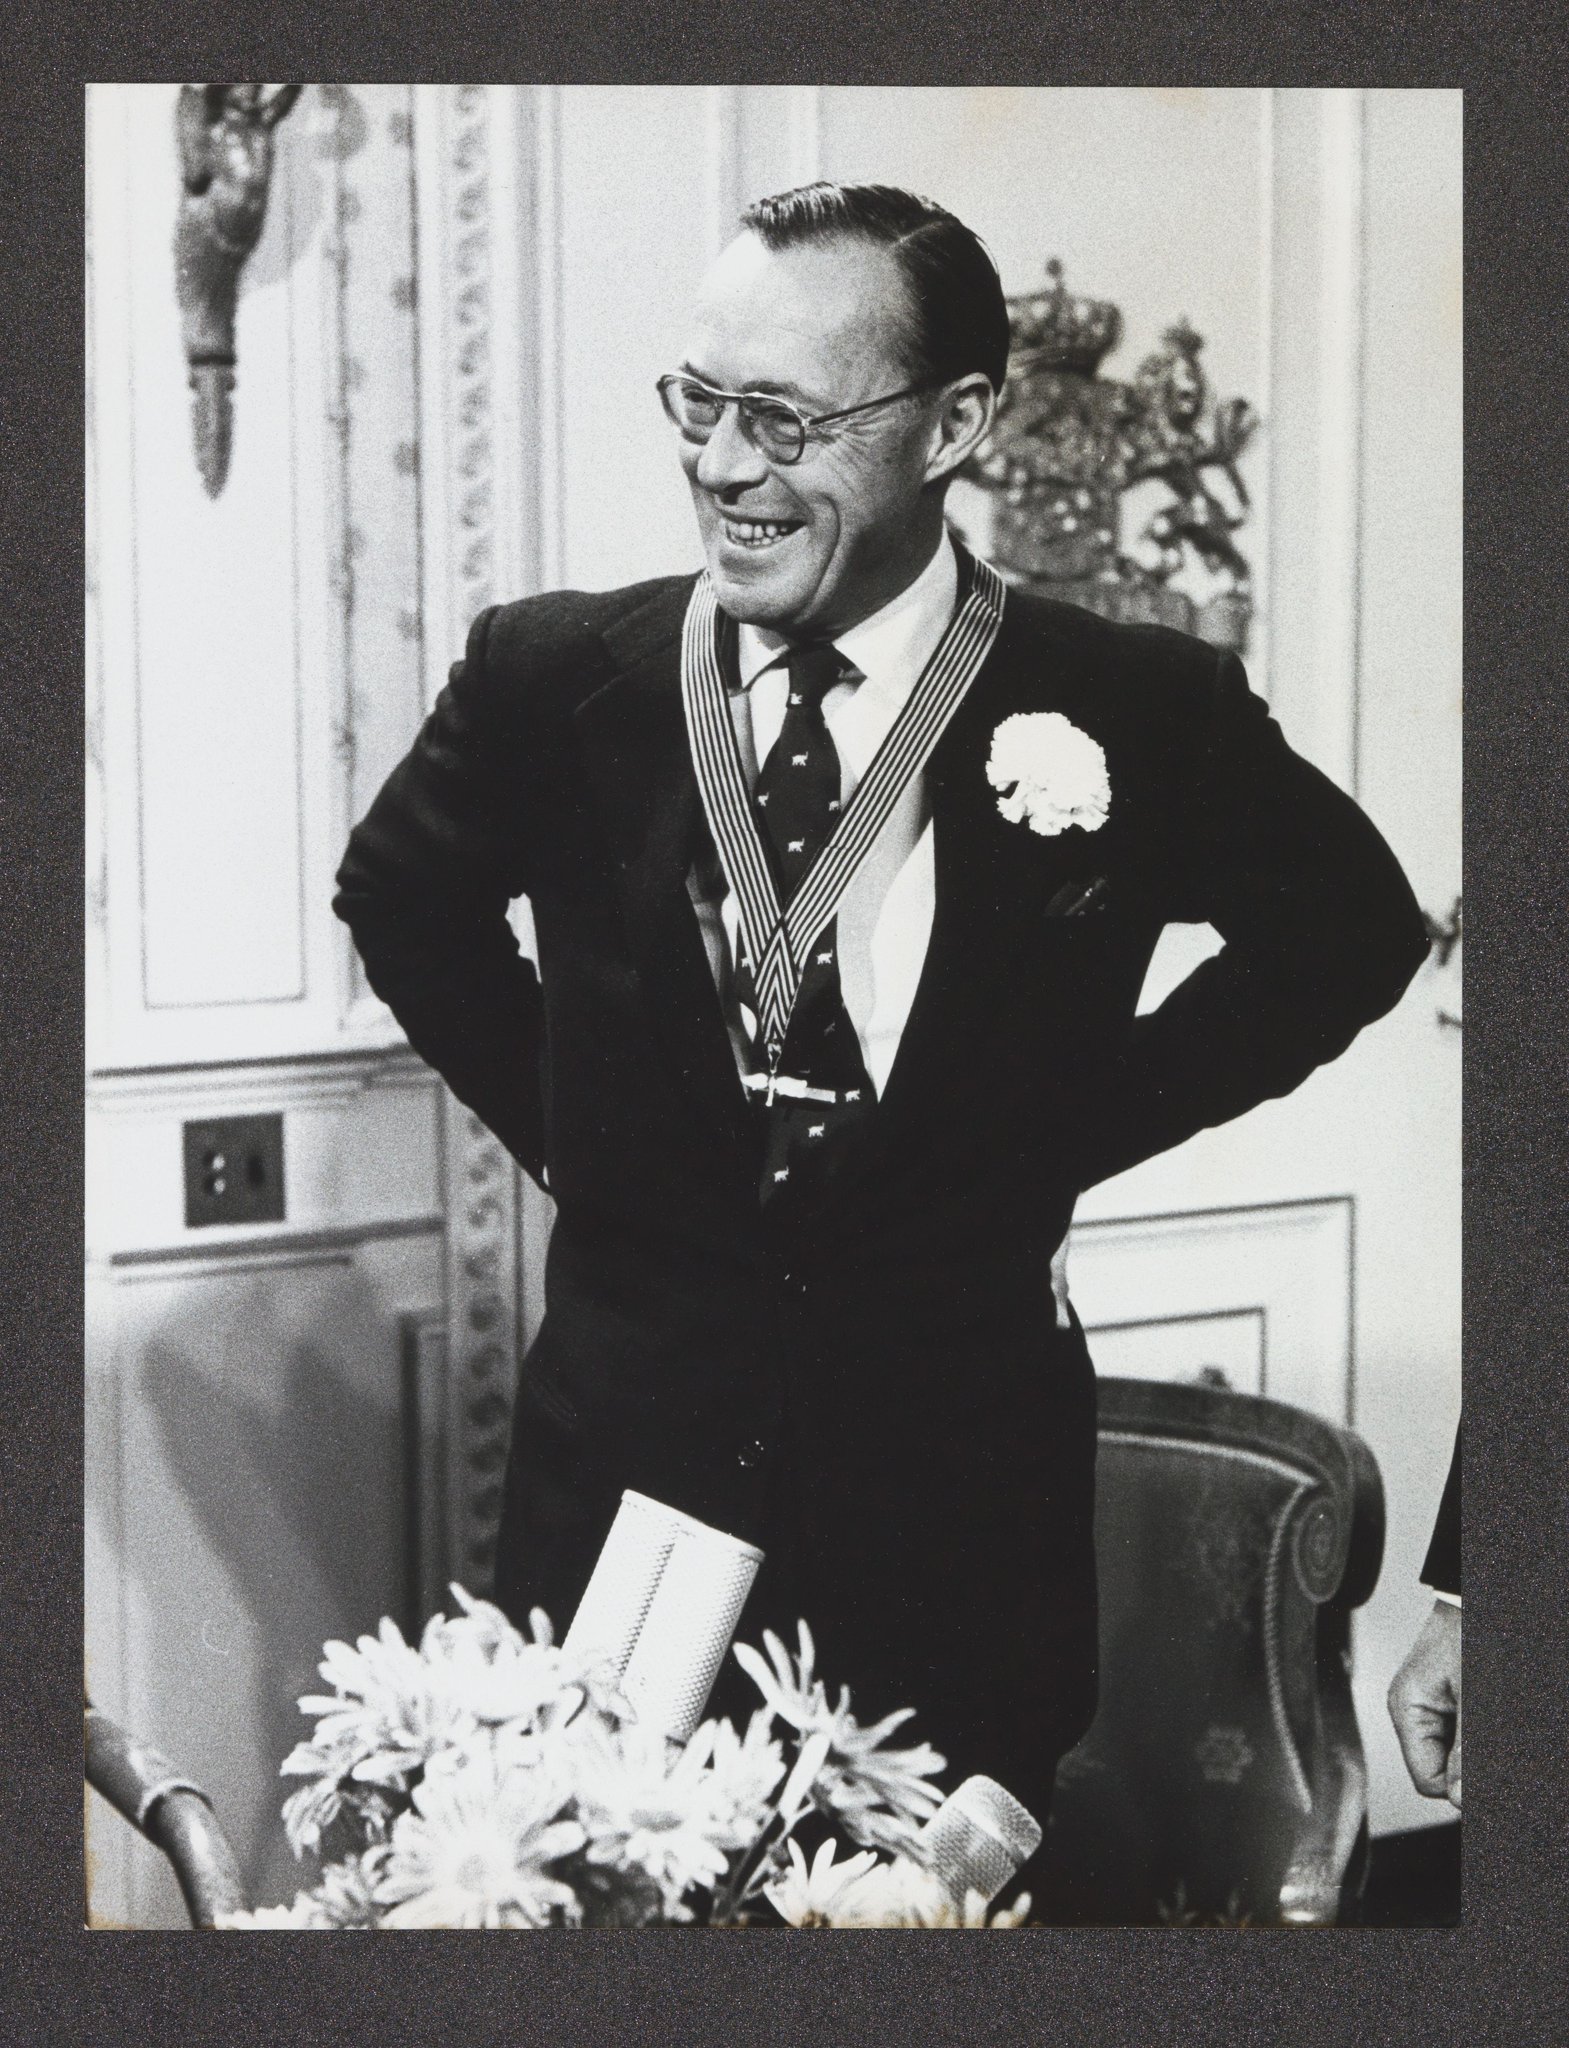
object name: photograph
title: Prins Bernhard wordt onderscheiden met de Zilveren Vlaamse Gaai voor de Nederlandse Scouting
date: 1943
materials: paper, photographic support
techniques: gelatin silver print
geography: netherlands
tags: utrecht, bernhard (prins der nederlanden)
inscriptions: stamp: ‘Copyright ANEFO Kerkstraat 310 Amsterdam - C no 165262-16’